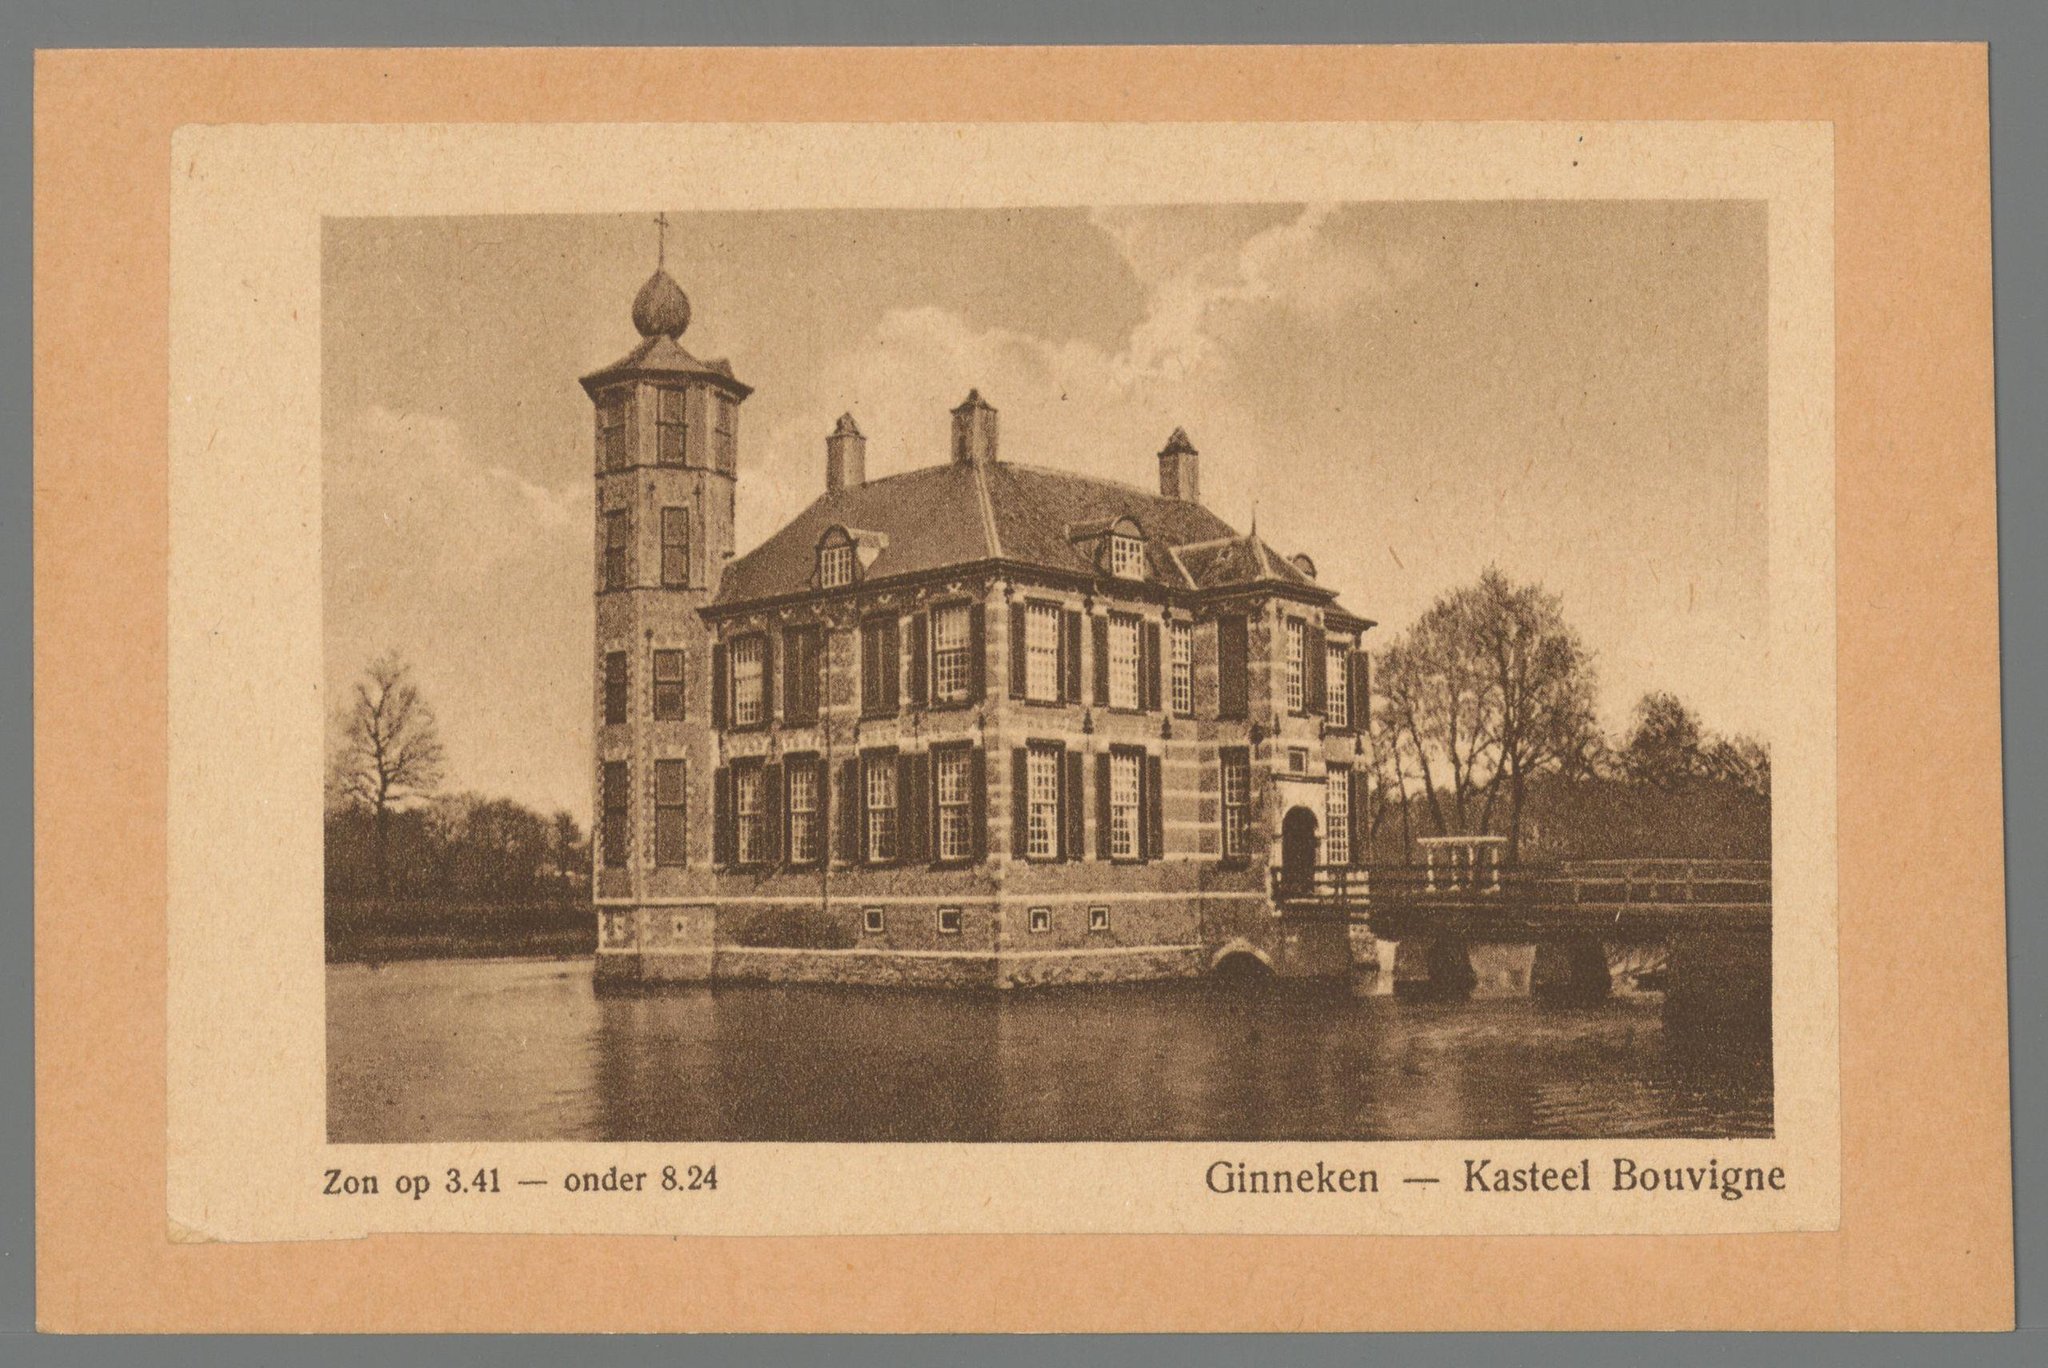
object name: photomechanical print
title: Ginneken - Kasteel Bouvigne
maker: Anonymous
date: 1895-1930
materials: cardboard, paper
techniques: rotogravure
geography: ginneken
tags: castle, canal, bridge